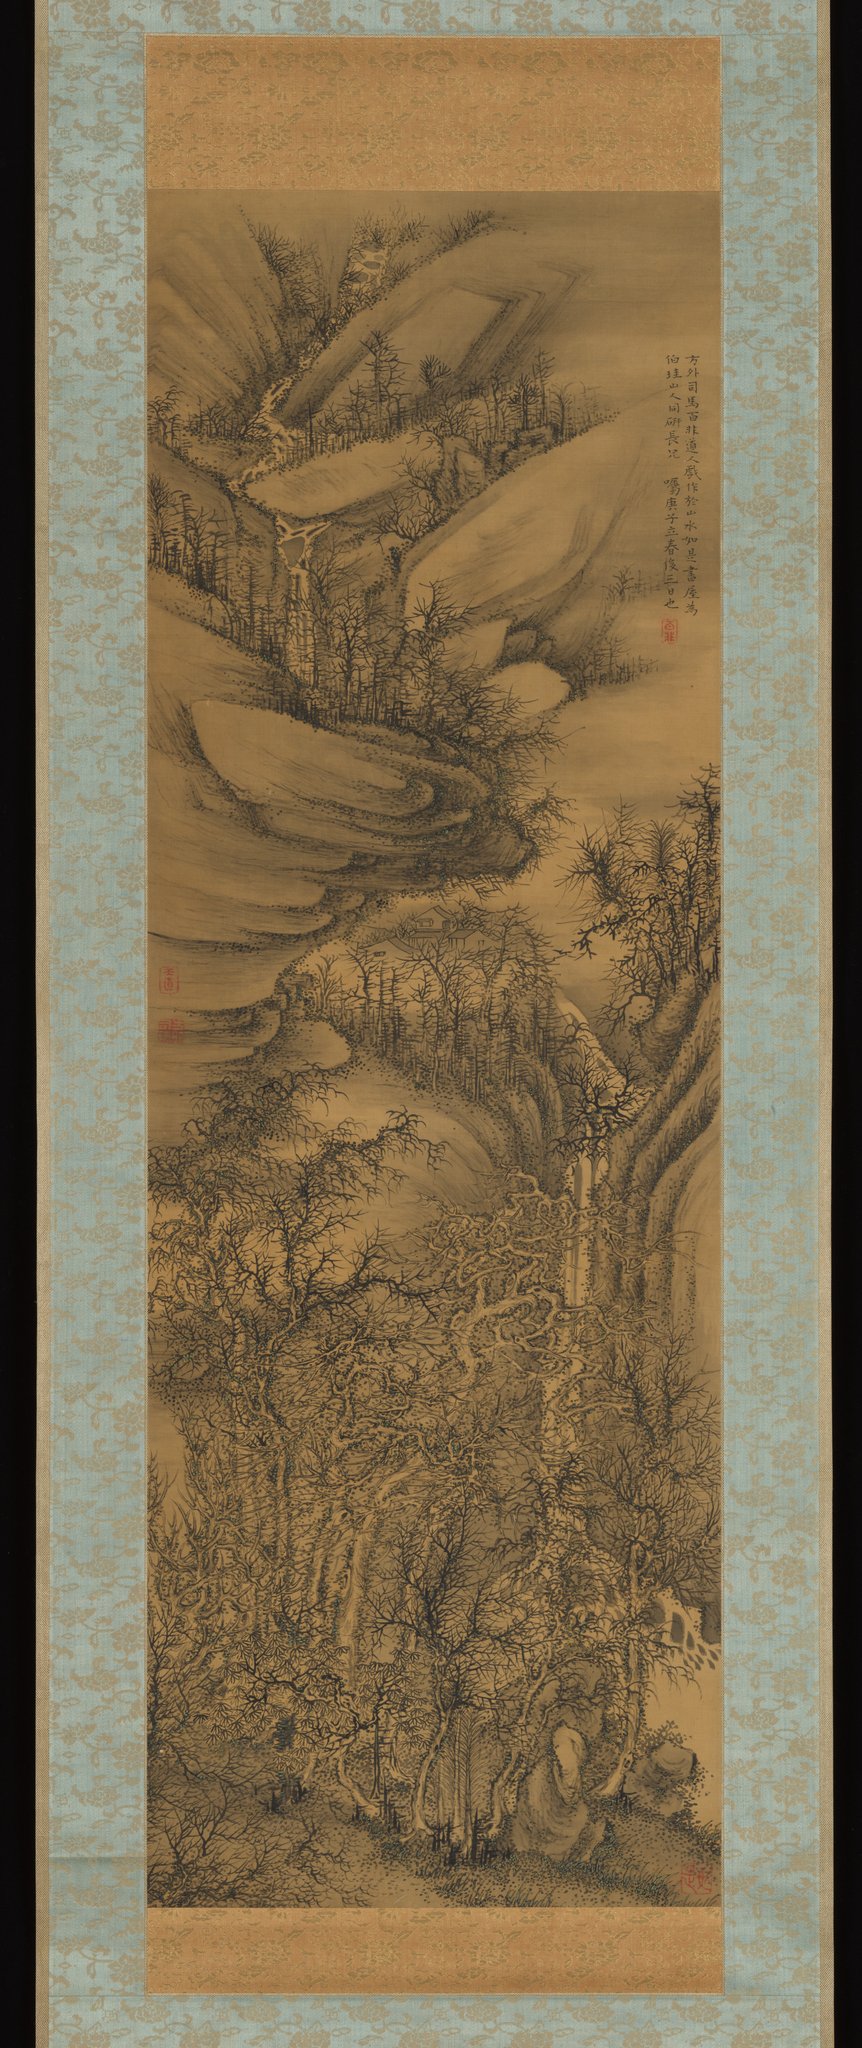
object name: hanging scroll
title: Winter Landscape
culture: japanese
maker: hayashi hyakuhi 林百非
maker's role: artist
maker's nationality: japanese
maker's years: 1797-1851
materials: ink, silk